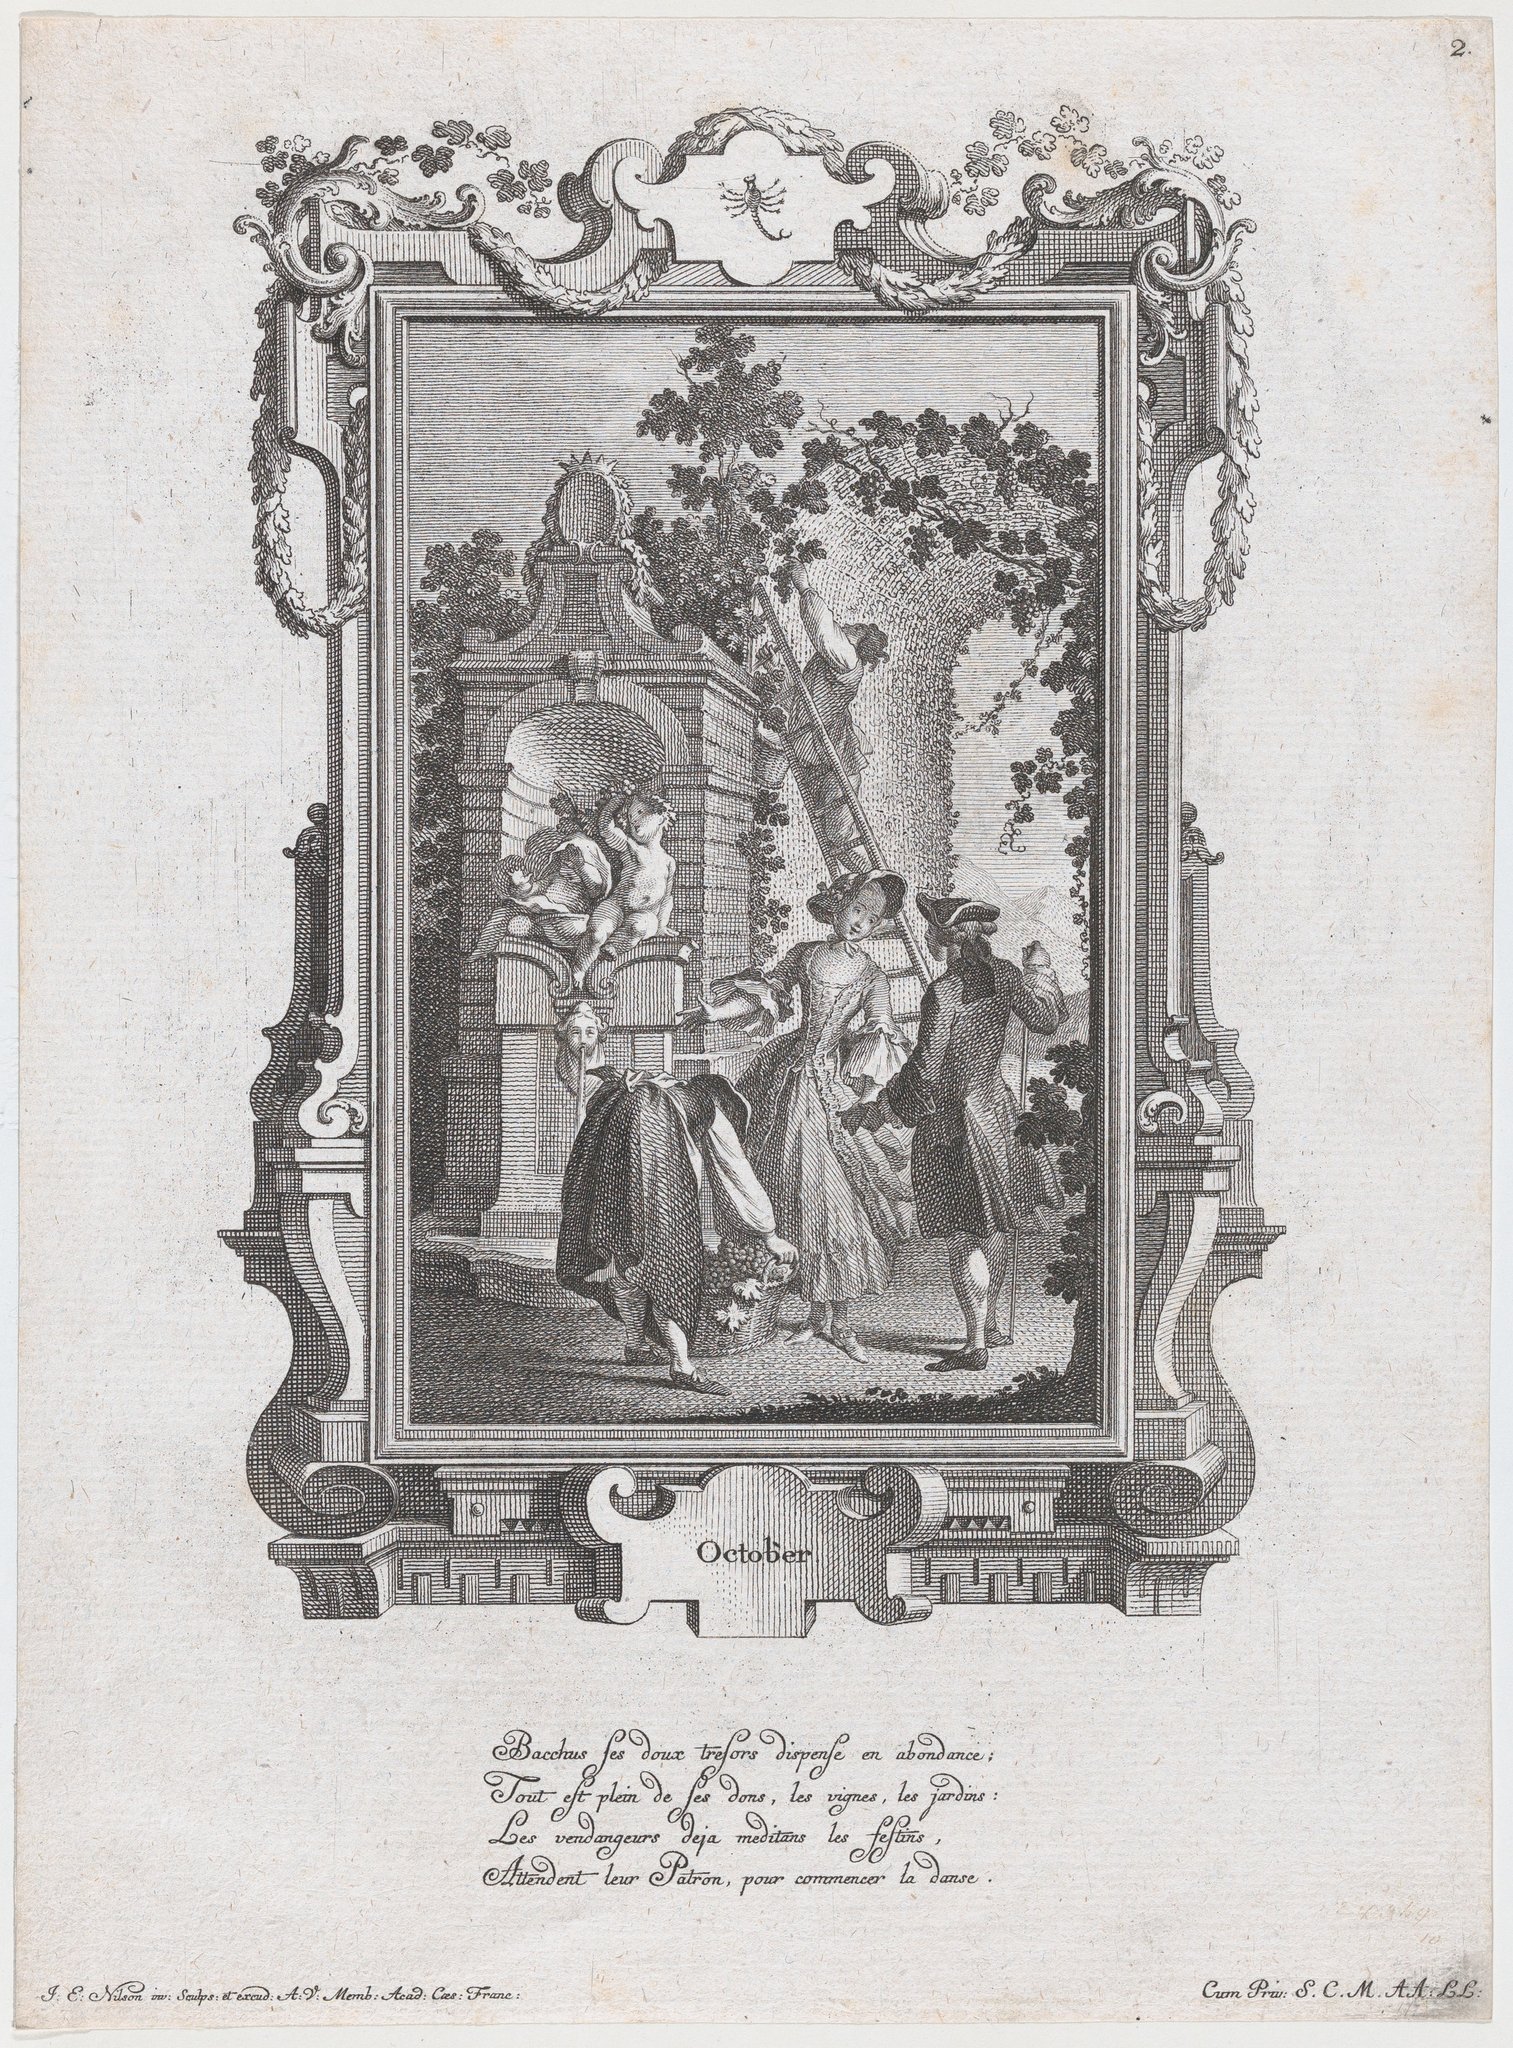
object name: print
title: October, from "Twelve Months of the Year"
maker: johann esaias nilson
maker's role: artist and publisher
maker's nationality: german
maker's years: 1721-1788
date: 1766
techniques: etching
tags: poetry,men,women,ladders